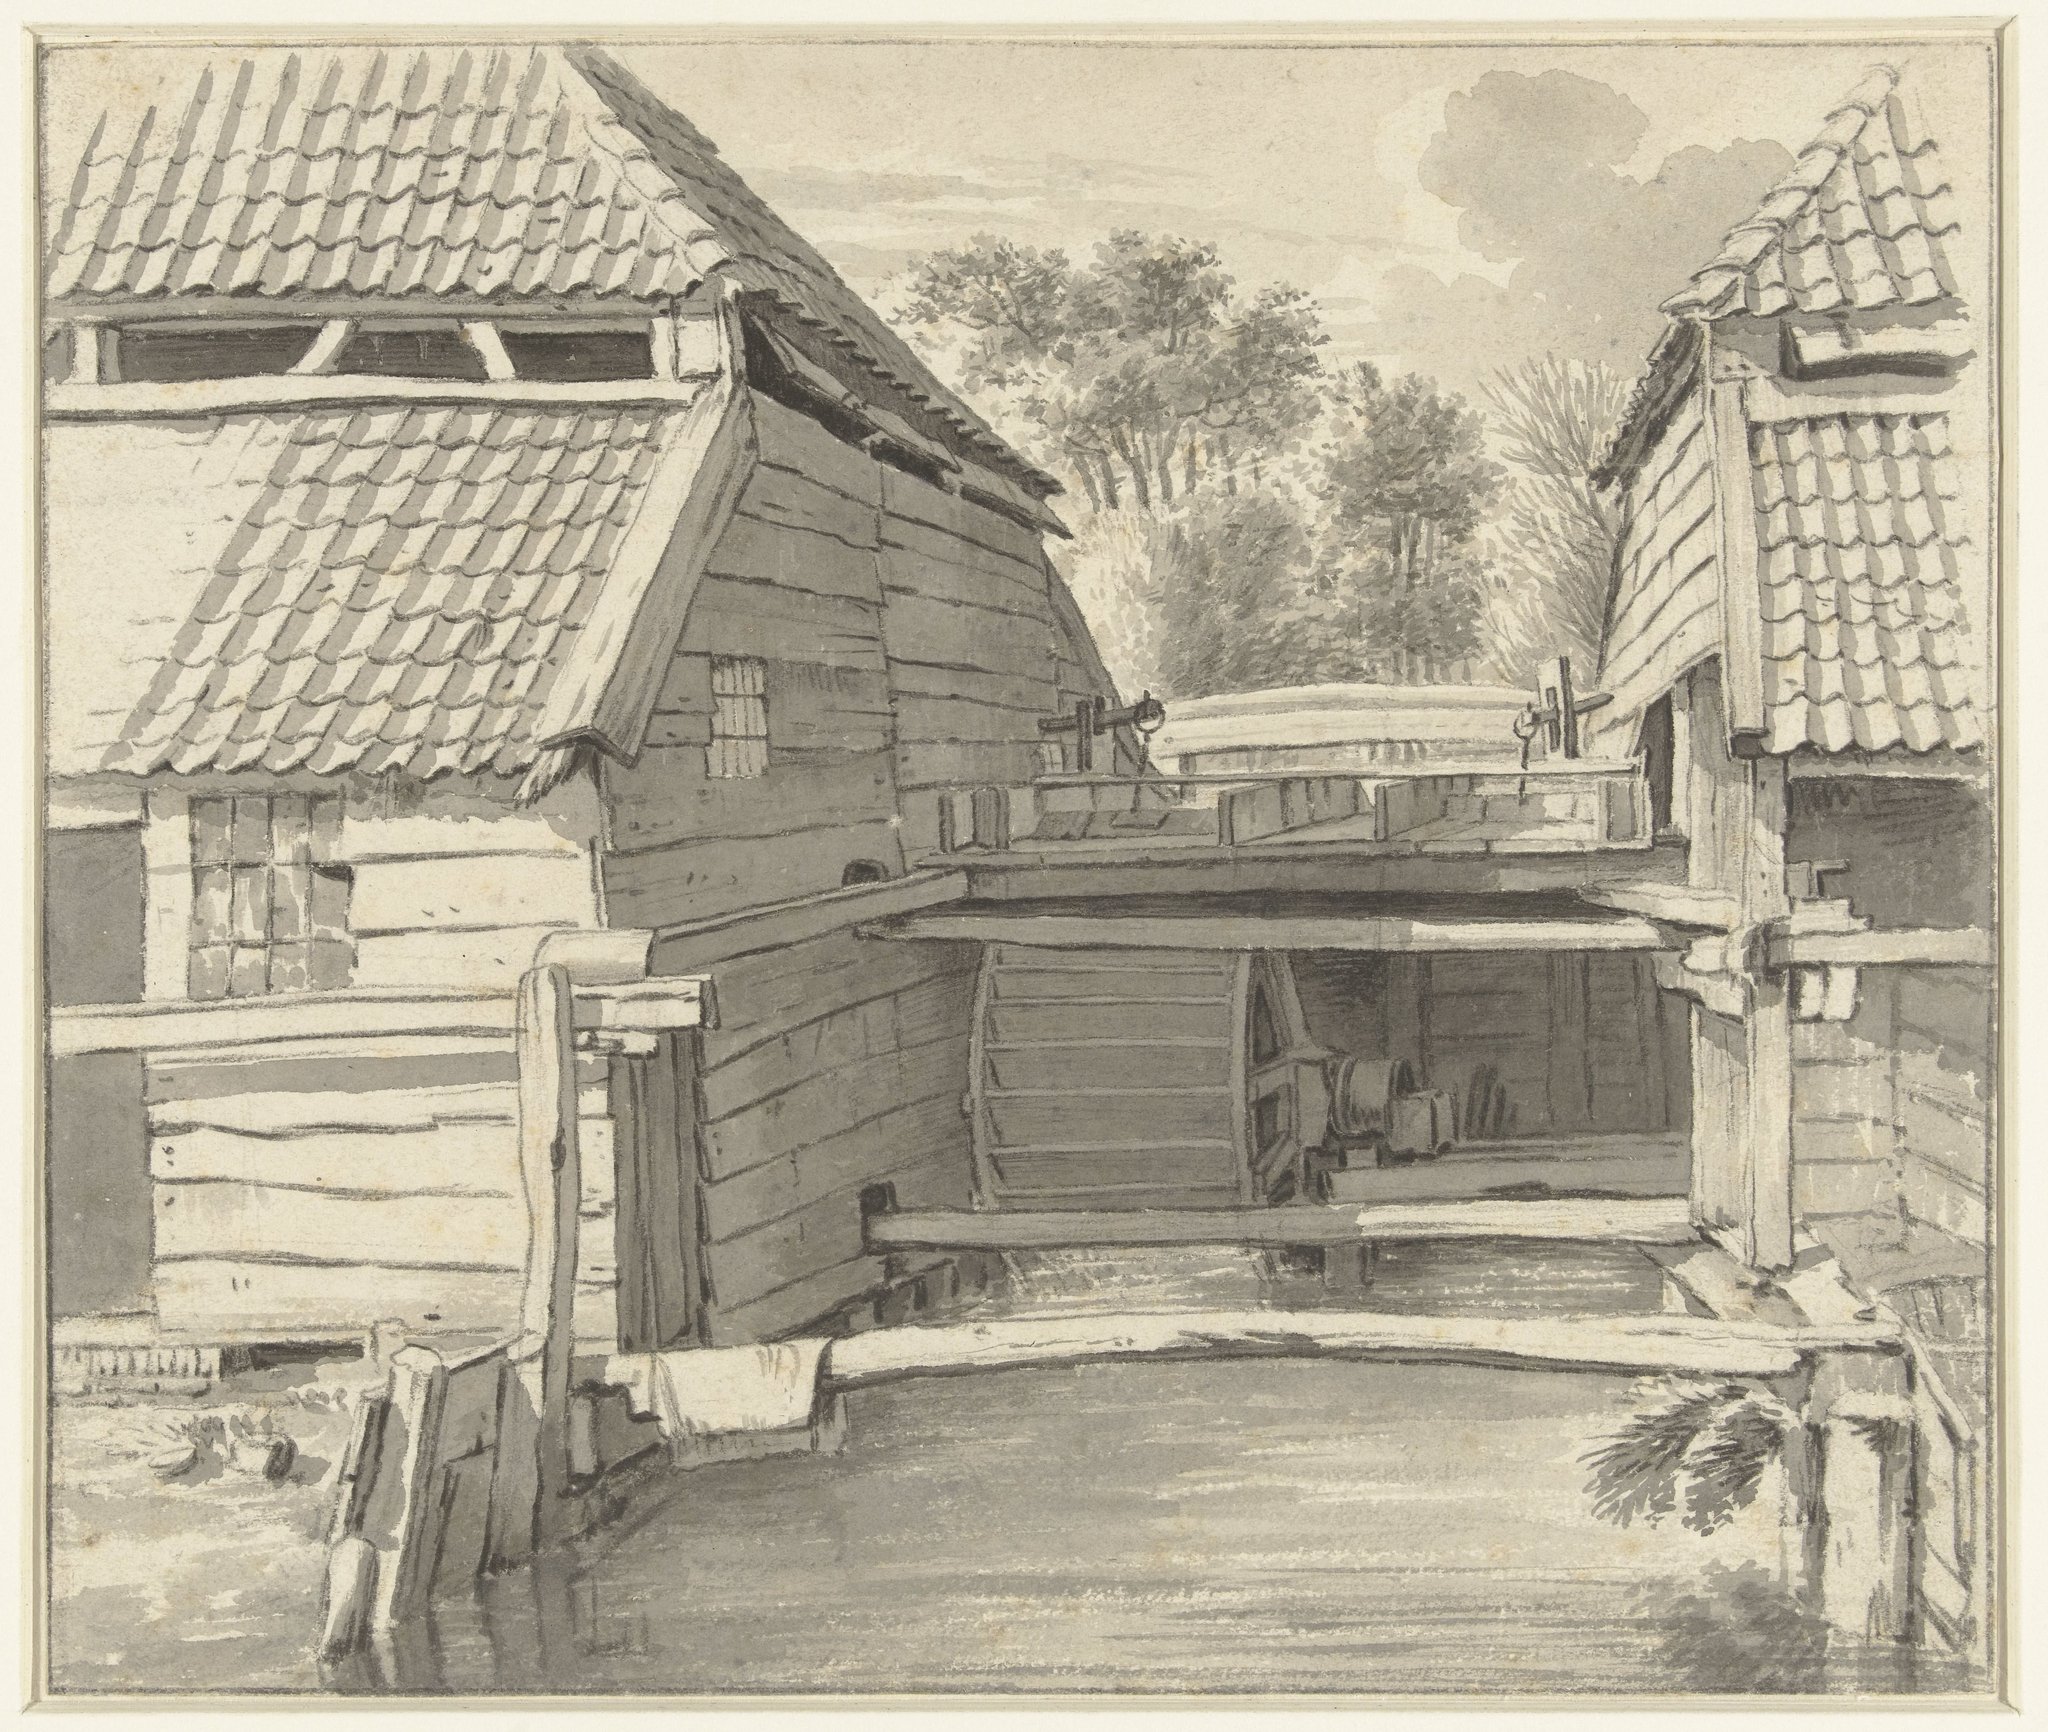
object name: drawing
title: Watermolen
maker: Anonymous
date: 1700-1800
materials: ink, paper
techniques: brush, pen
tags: watermill